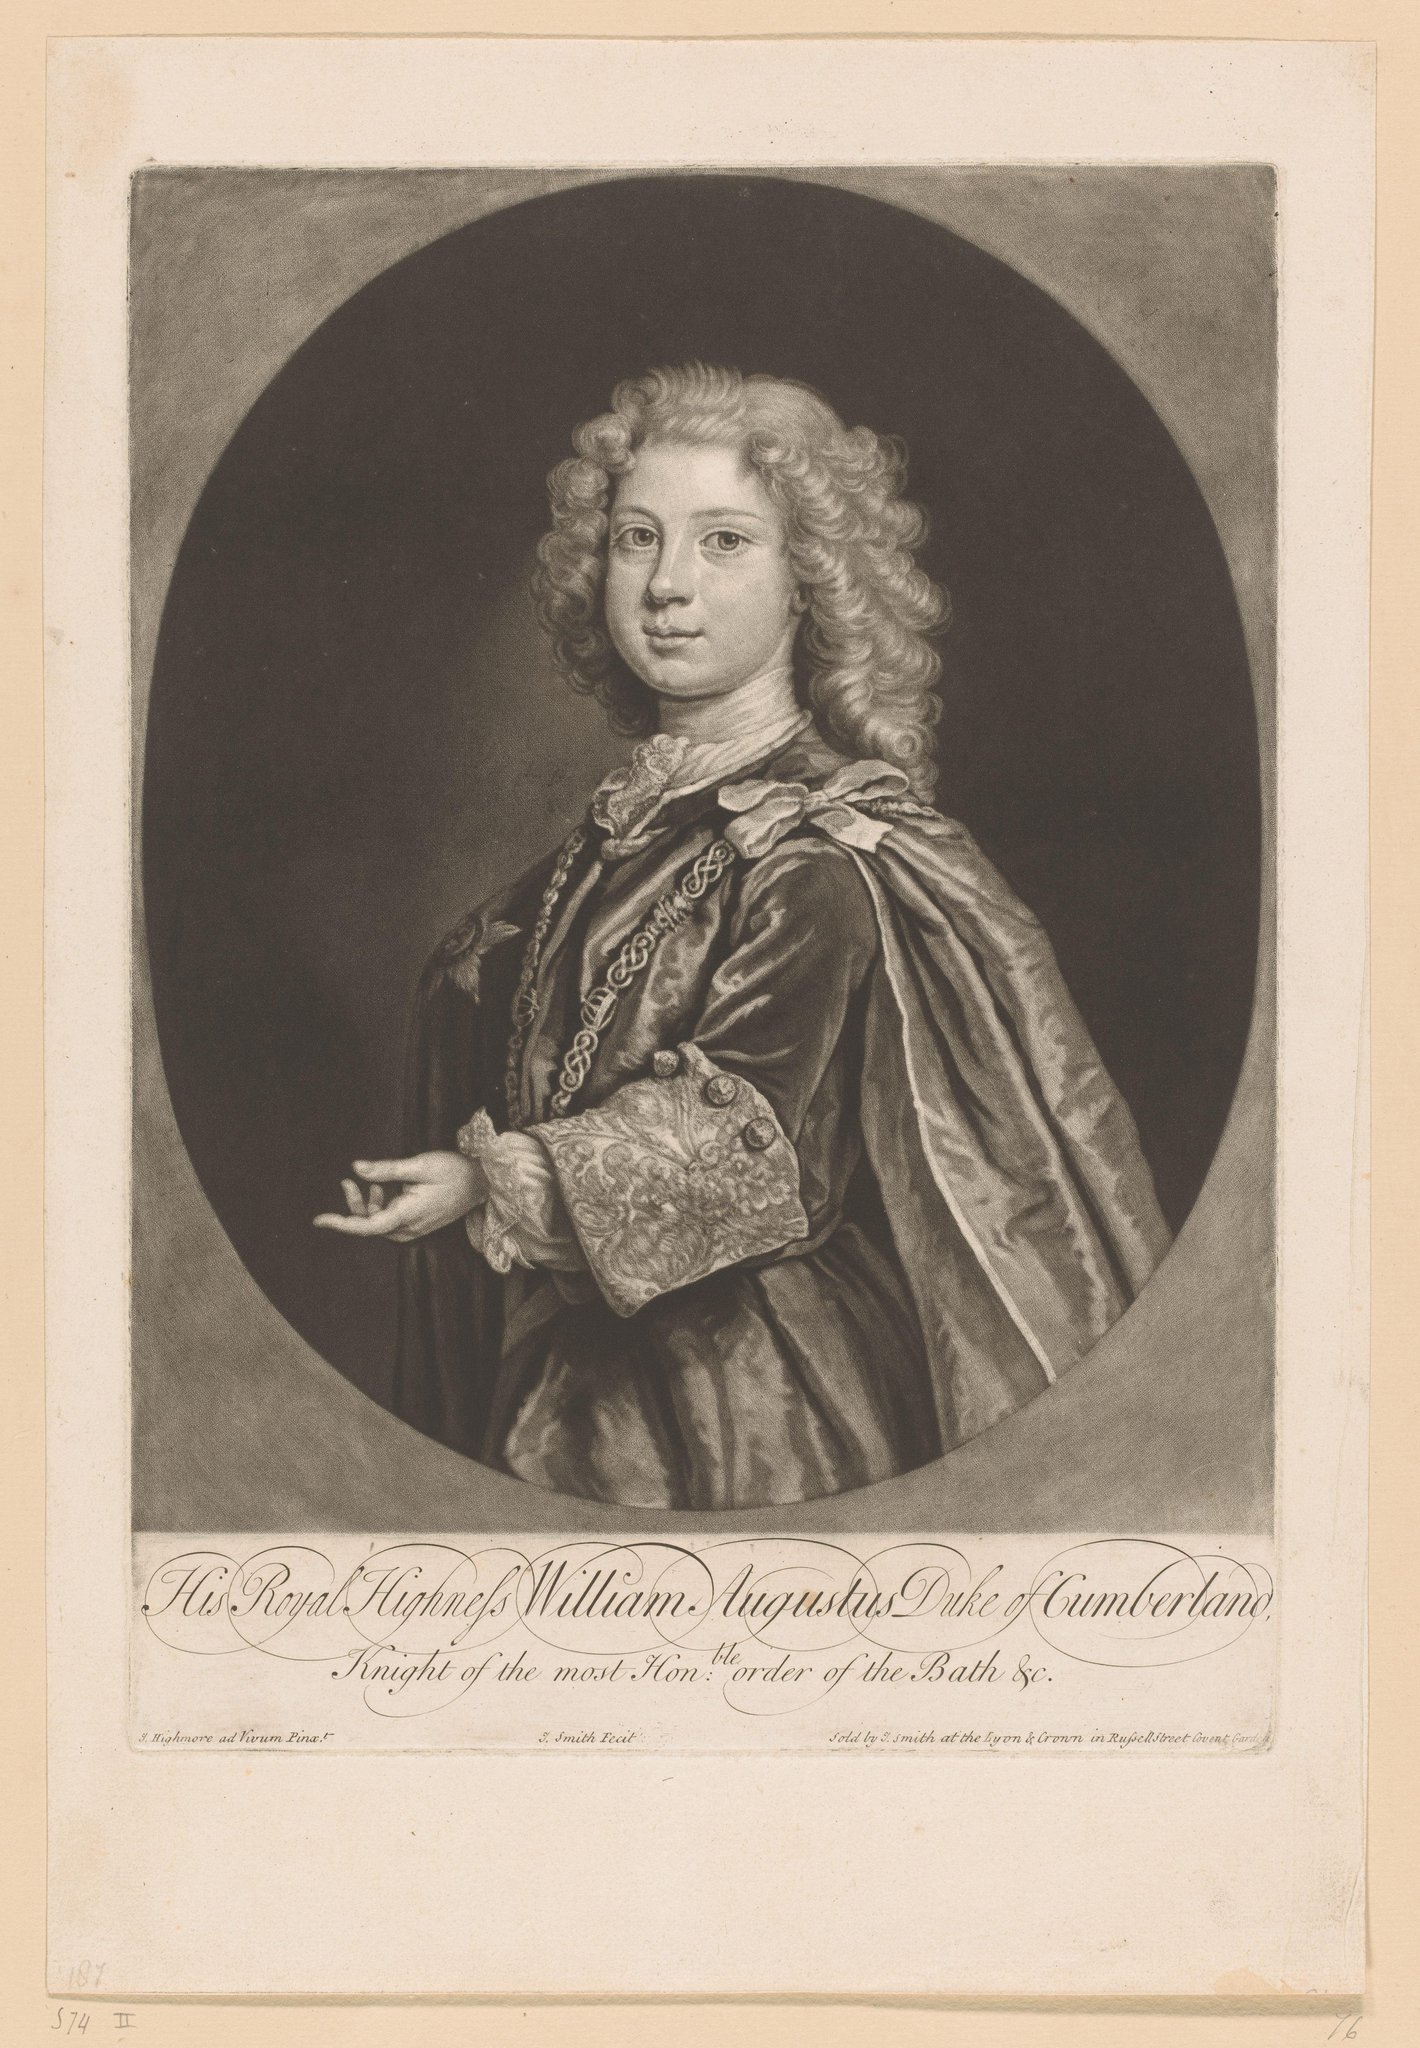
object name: print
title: Portret van William Augustus, hertog van Cumberland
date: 1731-1742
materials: paper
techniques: mezzotint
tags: historical persons, officer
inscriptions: collector's mark: Lugt 240